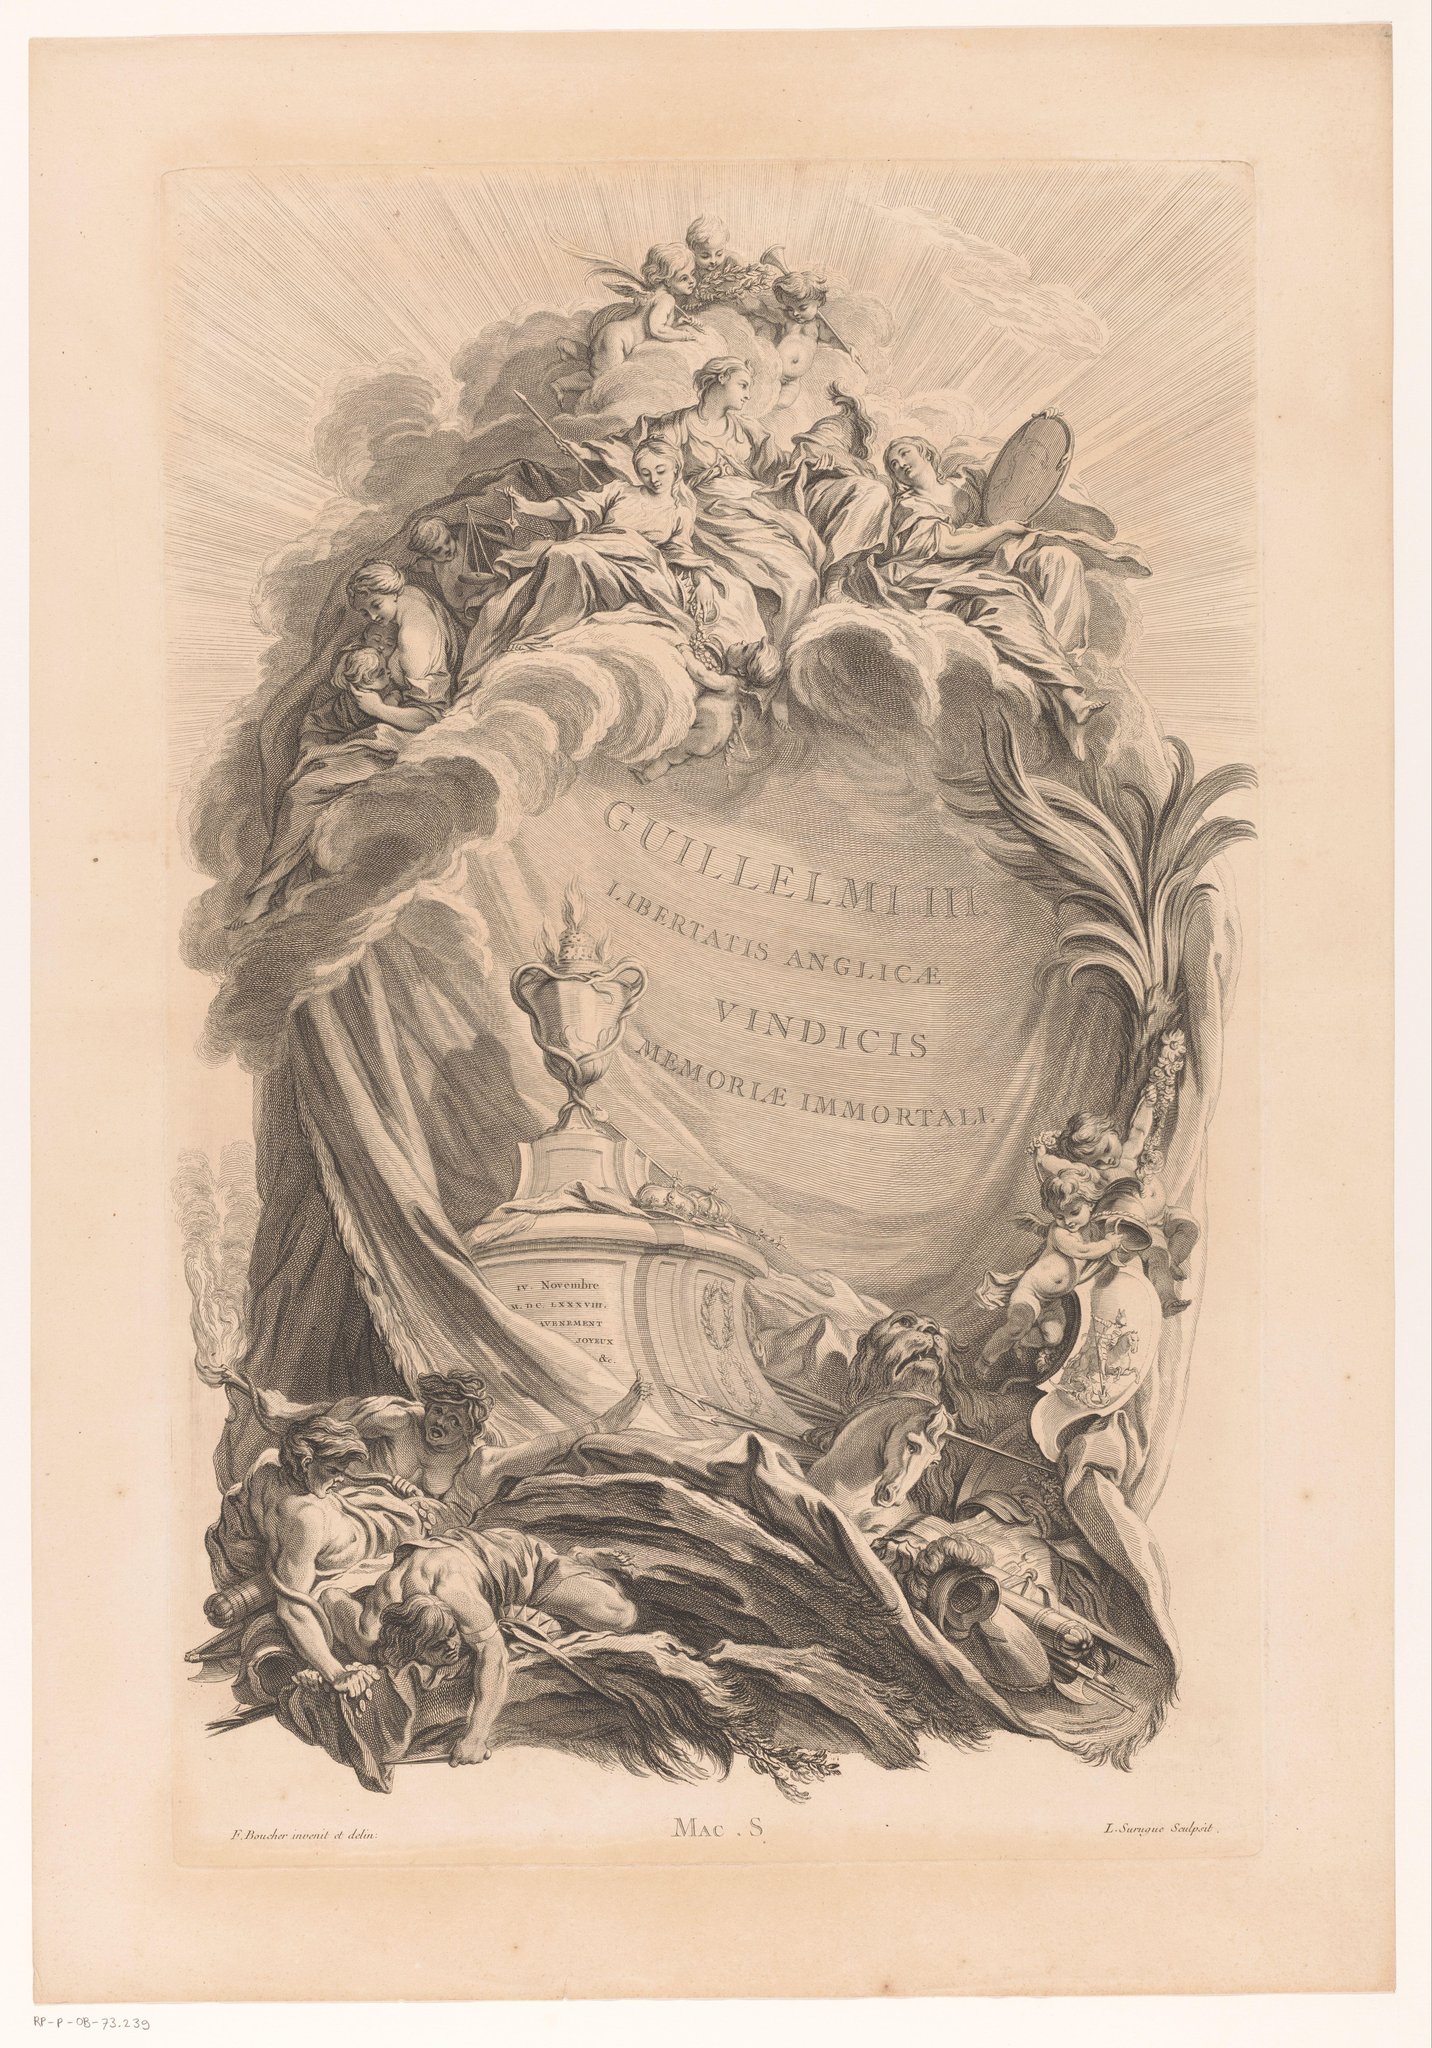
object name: print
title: Allegorie op Willem III, prins van Oranje en koning van Engeland, Schotland en Ierland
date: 1735-1741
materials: paper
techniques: engraving, etching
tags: the hague, william iii (prince of orange and king of england, scotland, and ireland), unicorn, justitia (justice) as roman personification, prudentia (prudence) as roman personification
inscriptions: collector's mark: Lugt 2228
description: Maakt deel uit van een twintigdelige serie met prenten van grafmonumenten van illustere Britten naar schilderijen uit de collectie van de Duke of Richmond. De serie bestaat uit prenten door verschillende kunstenaars en werd eerst uitgegeven door Mac Swiny en daarna door Basan. Dit betreft de prent voorafgaand aan het allegorisch grafmonument voor Willem III, prins van Oranje en koning van Engeland, Schotland en Ierland.